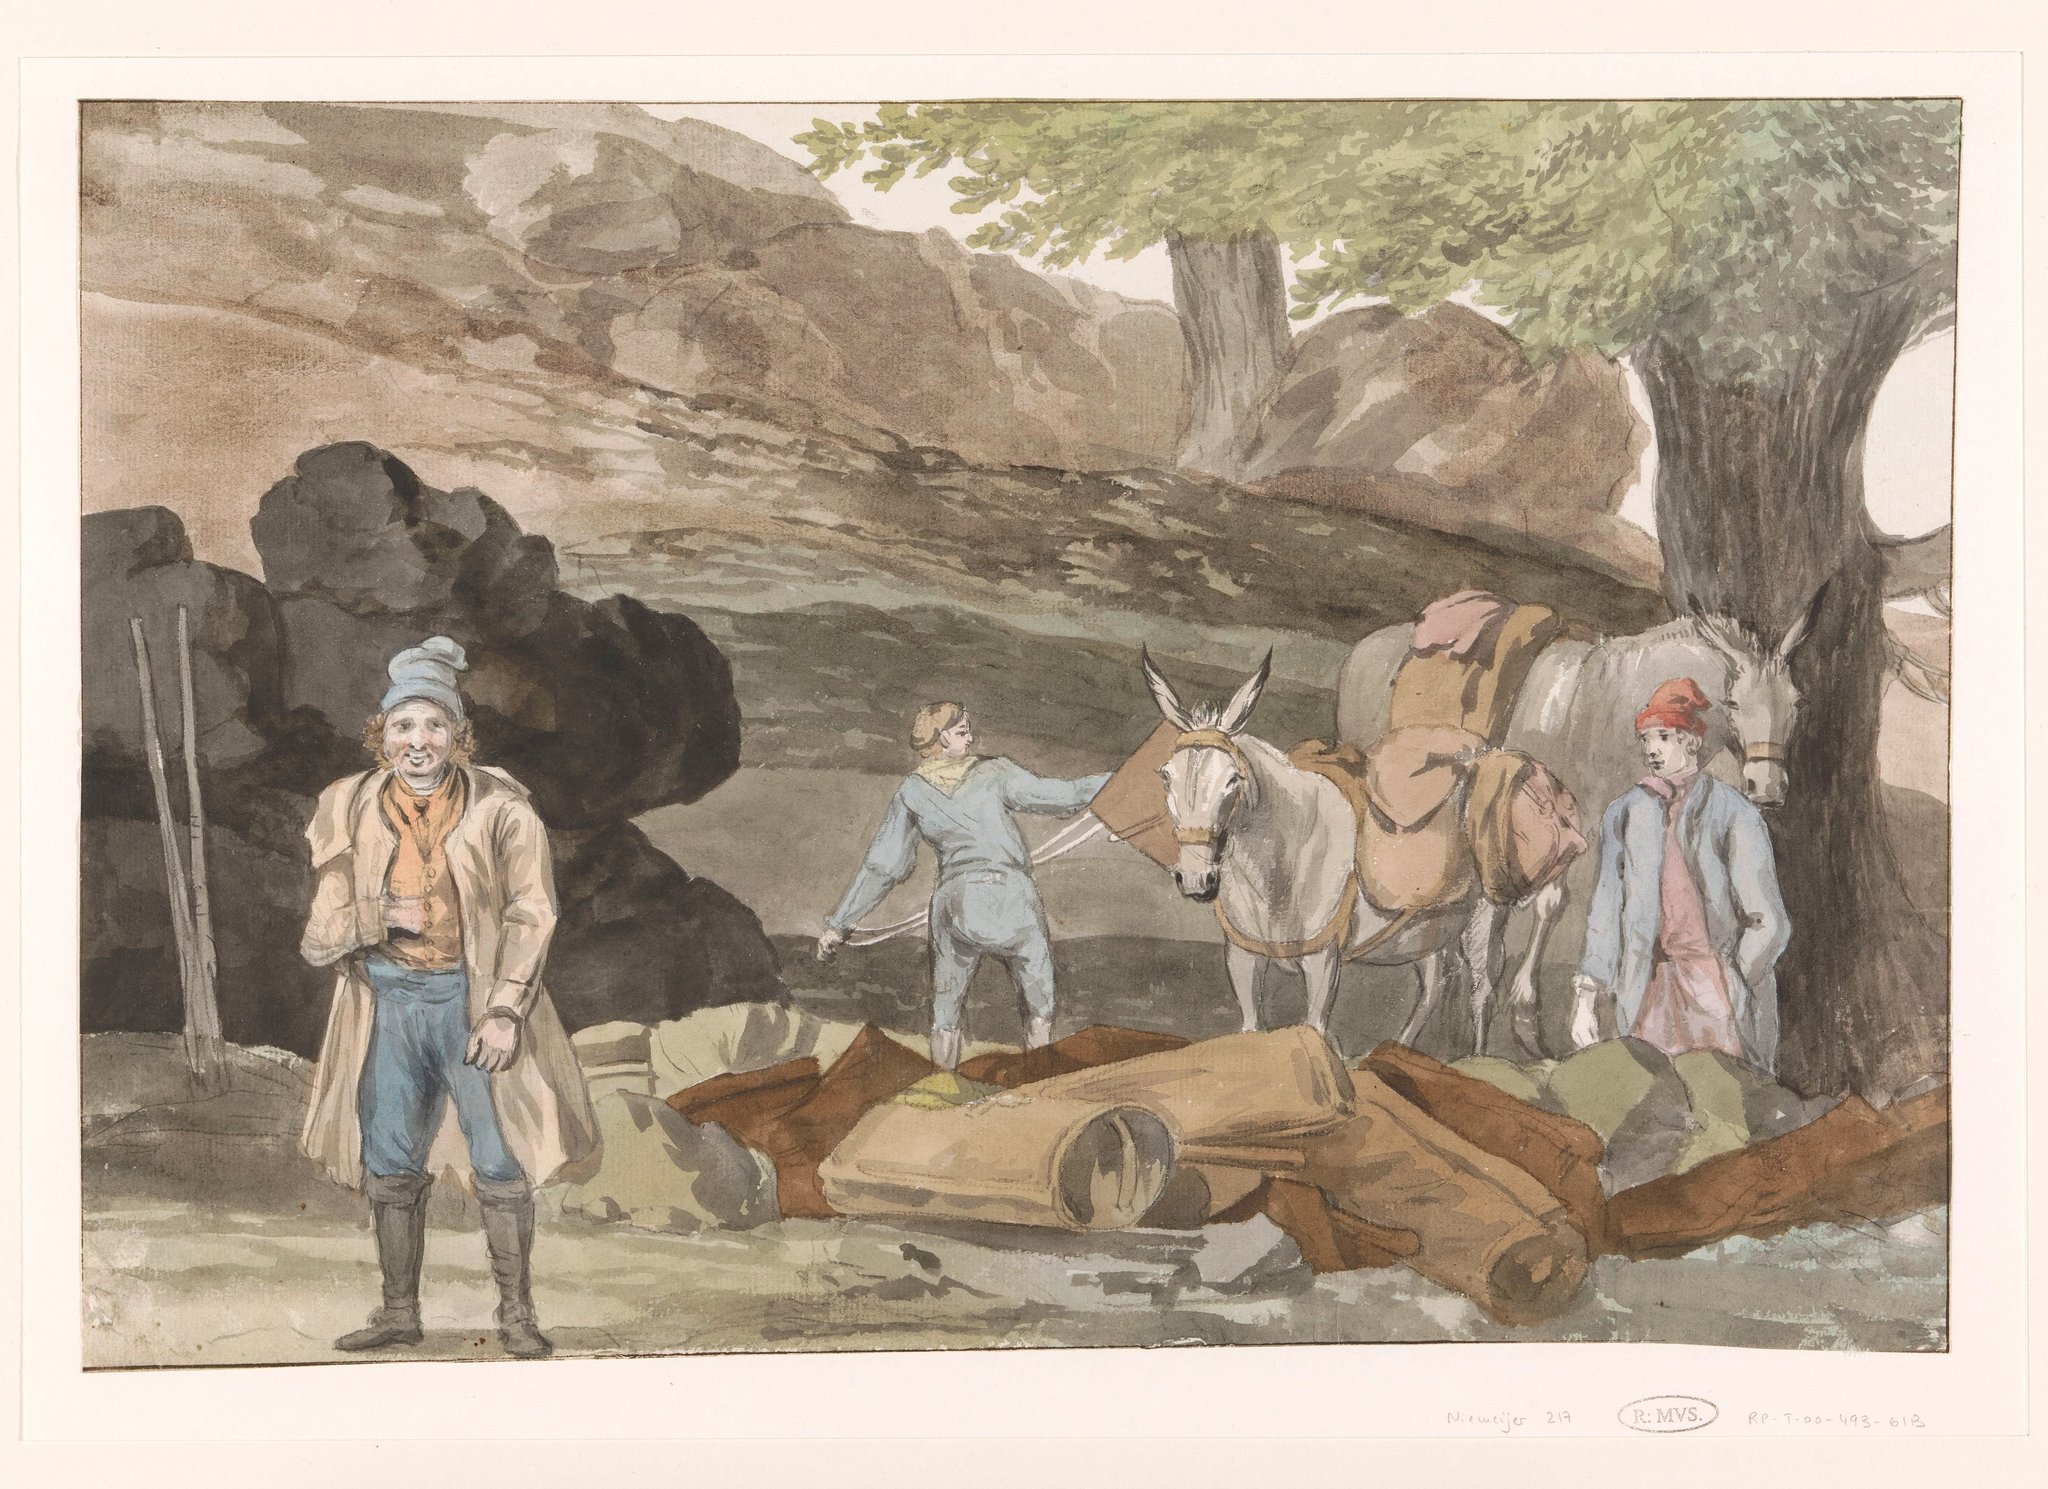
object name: watercolor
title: Voyage en Italie, en Sicile et à Malte - 1778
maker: louis ducros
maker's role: draughtsman, print maker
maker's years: 1748-1810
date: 1778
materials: chalk, paper, watercolor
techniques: brush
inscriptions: number: ‘No 173 Halte à la grotte delle Capre aux confins des deux Régions Nemorosa & Fredda’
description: Tekening uit het album 'Voyage en Italie, en Sicile et à Malte', 1778.